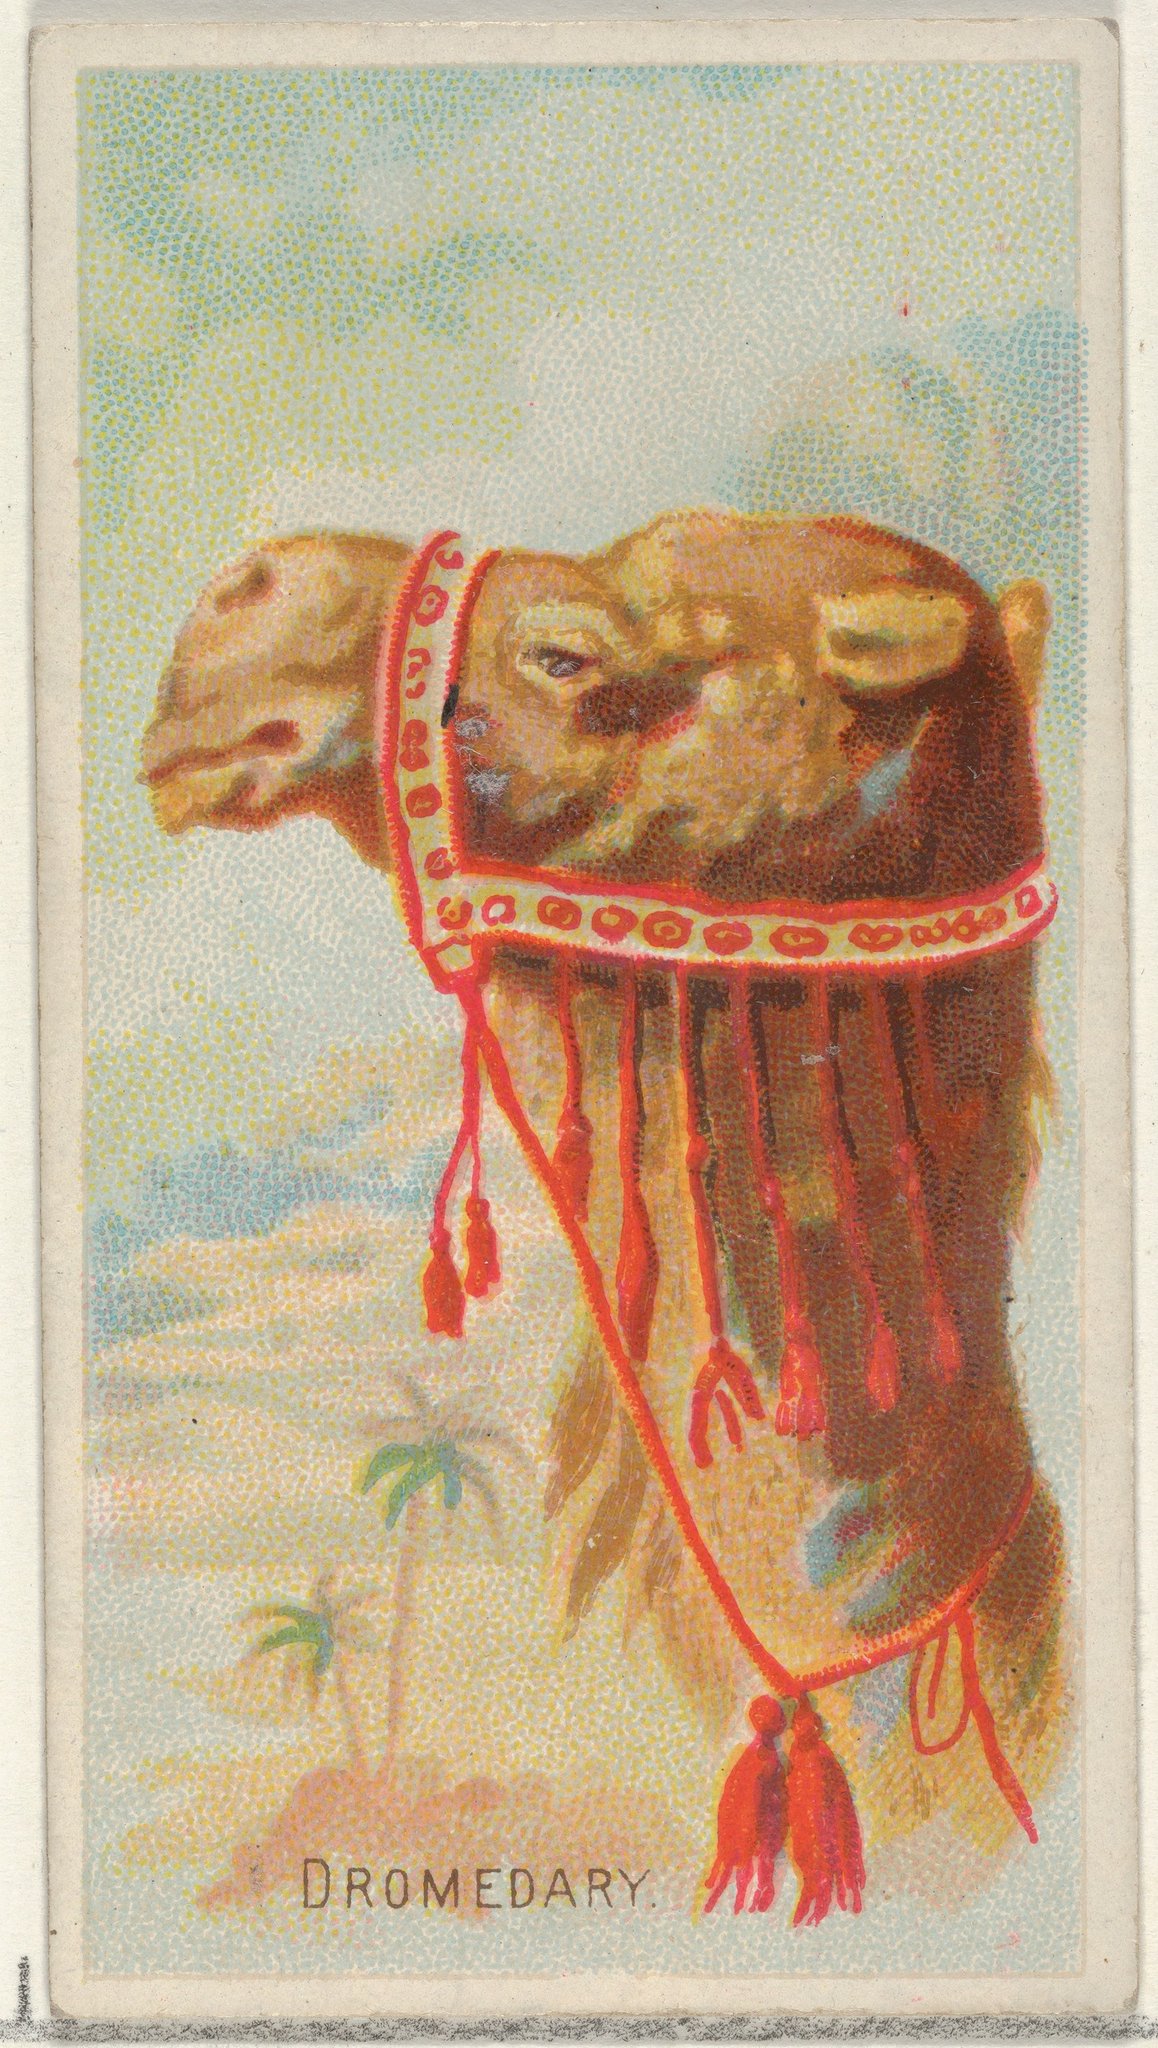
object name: print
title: Dromedary, from the Wild Animals of the World series (N25) for Allen & Ginter Cigarettes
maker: allen & ginter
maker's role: publisher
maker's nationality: american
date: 1888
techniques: color lithograph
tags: camels